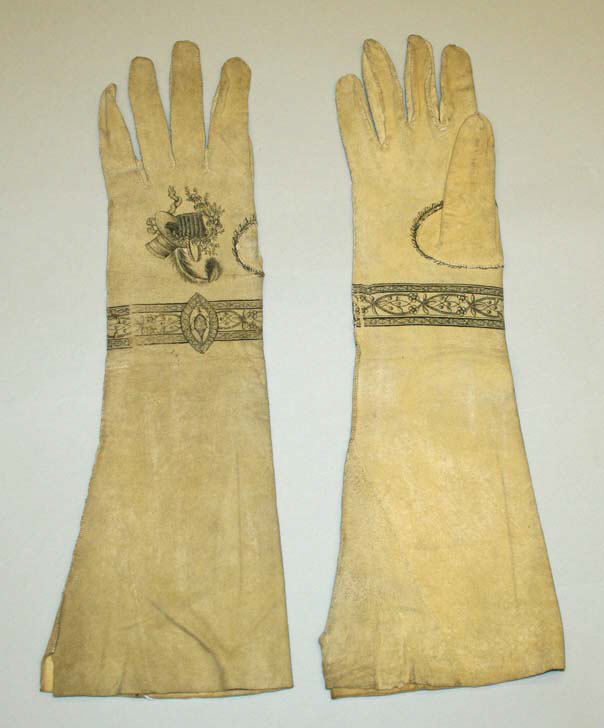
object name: glove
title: Gloves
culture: american or european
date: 1800-1825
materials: leather